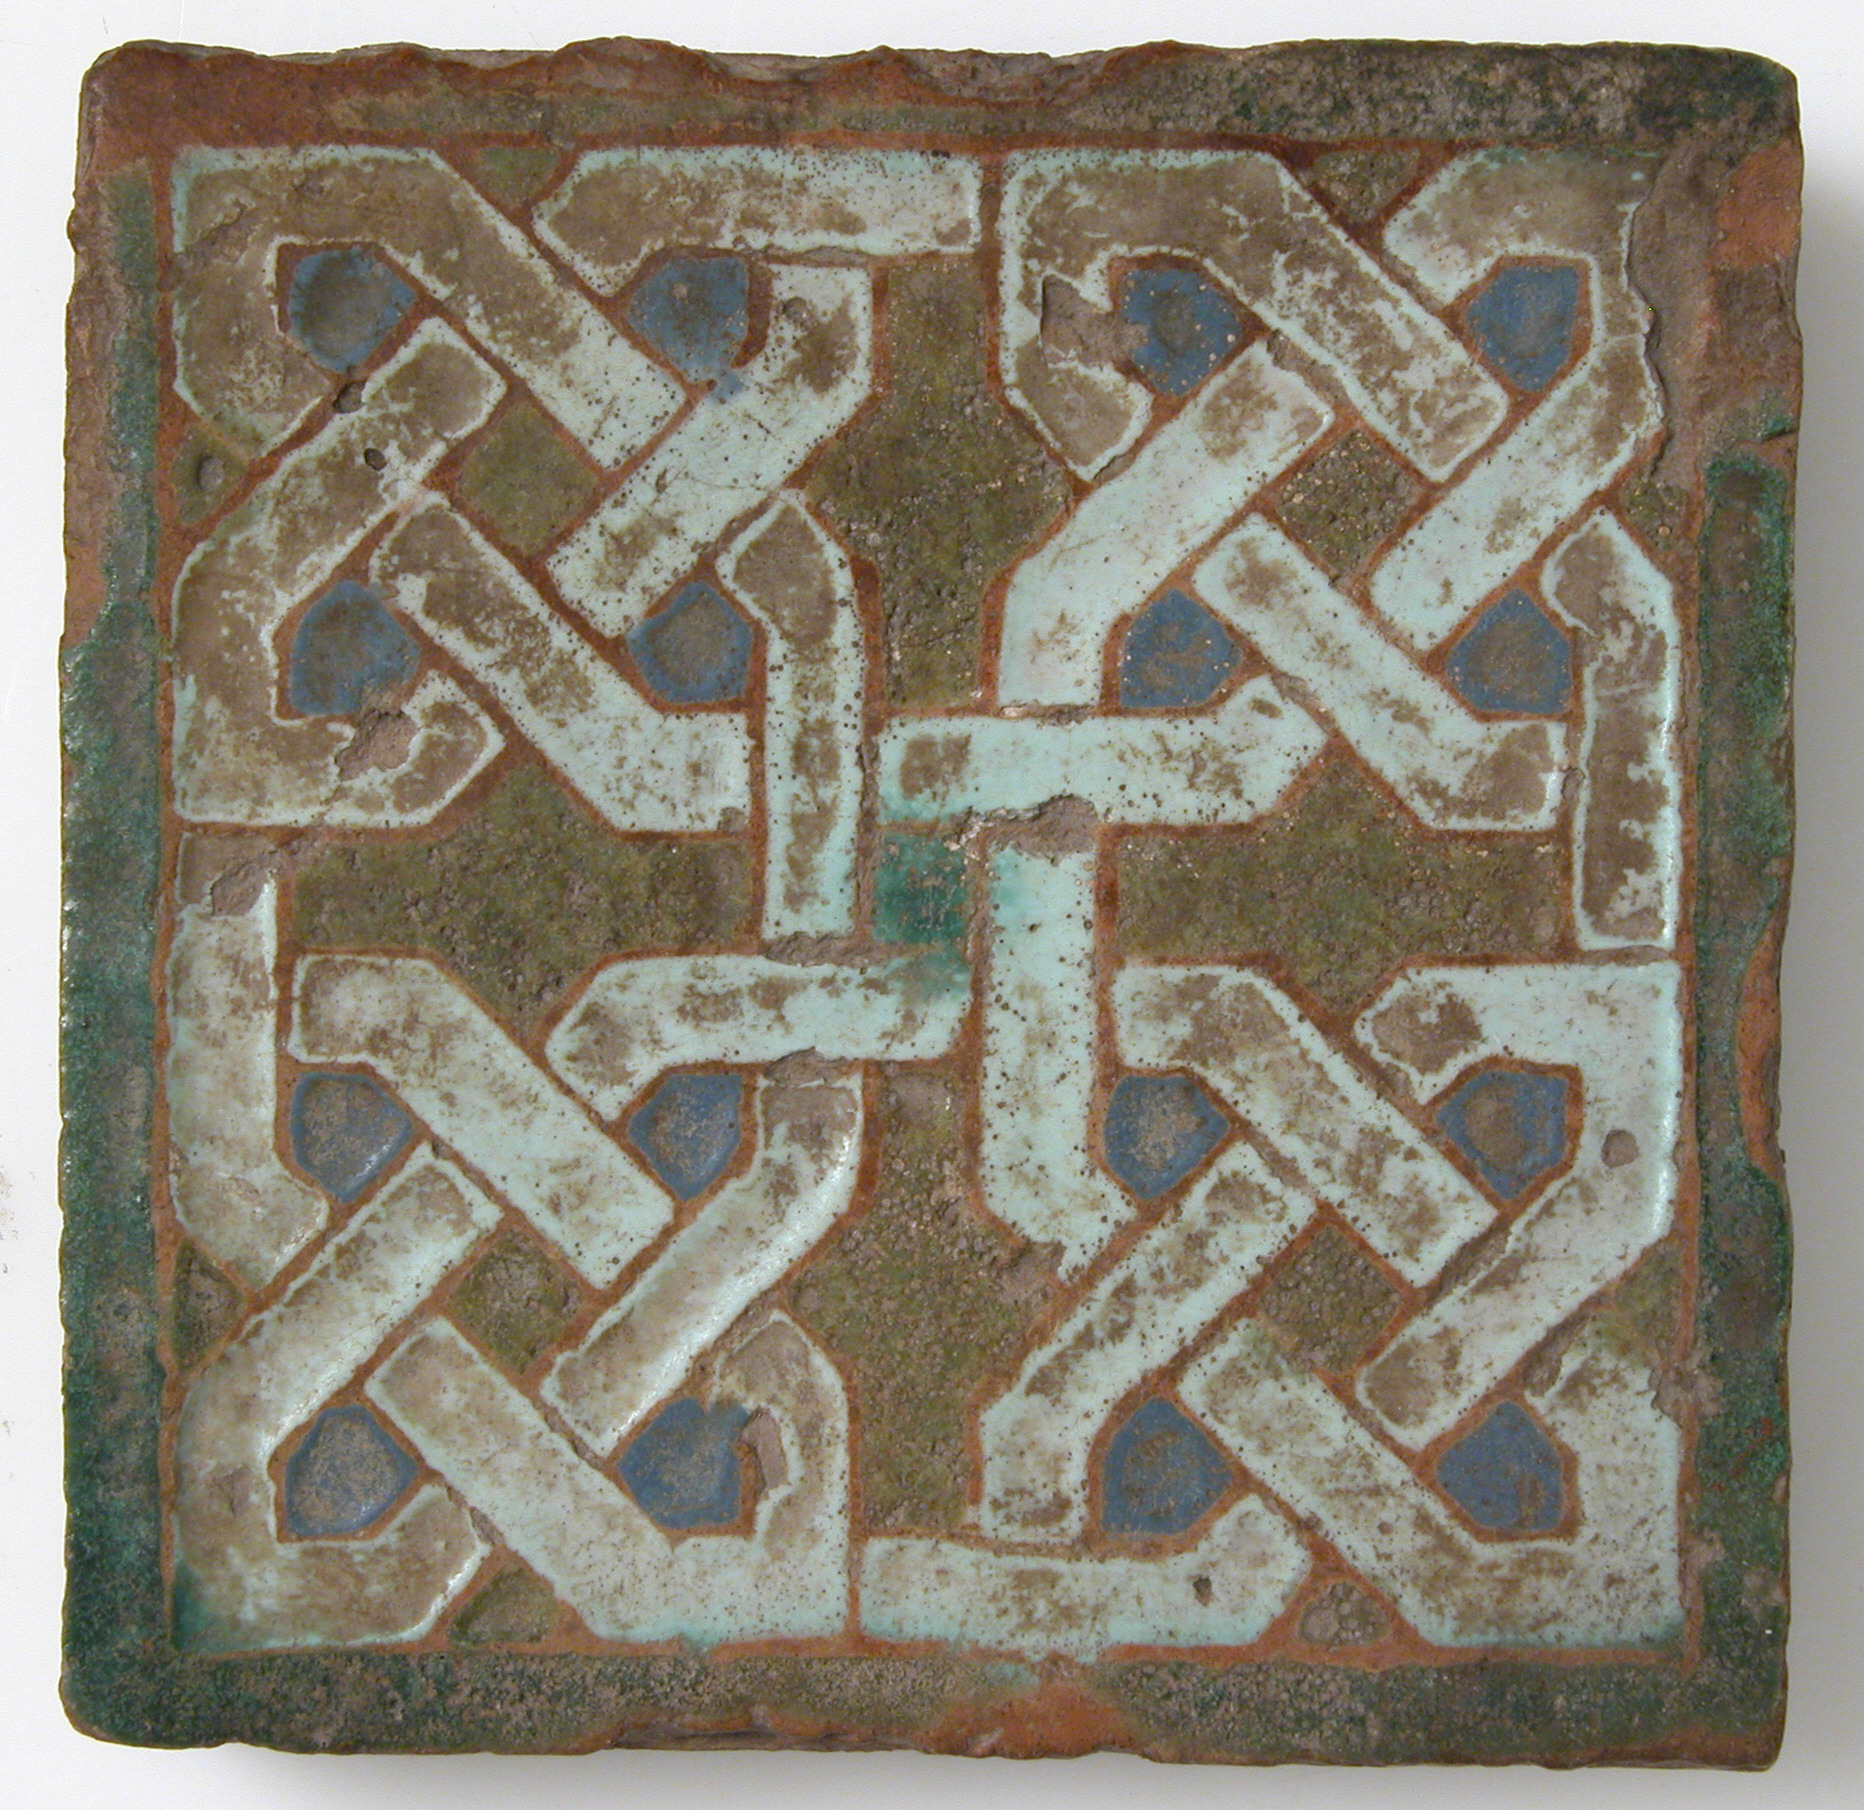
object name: tile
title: Wall Tile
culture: spanish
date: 1401-1500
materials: earthenware, glaze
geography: spain